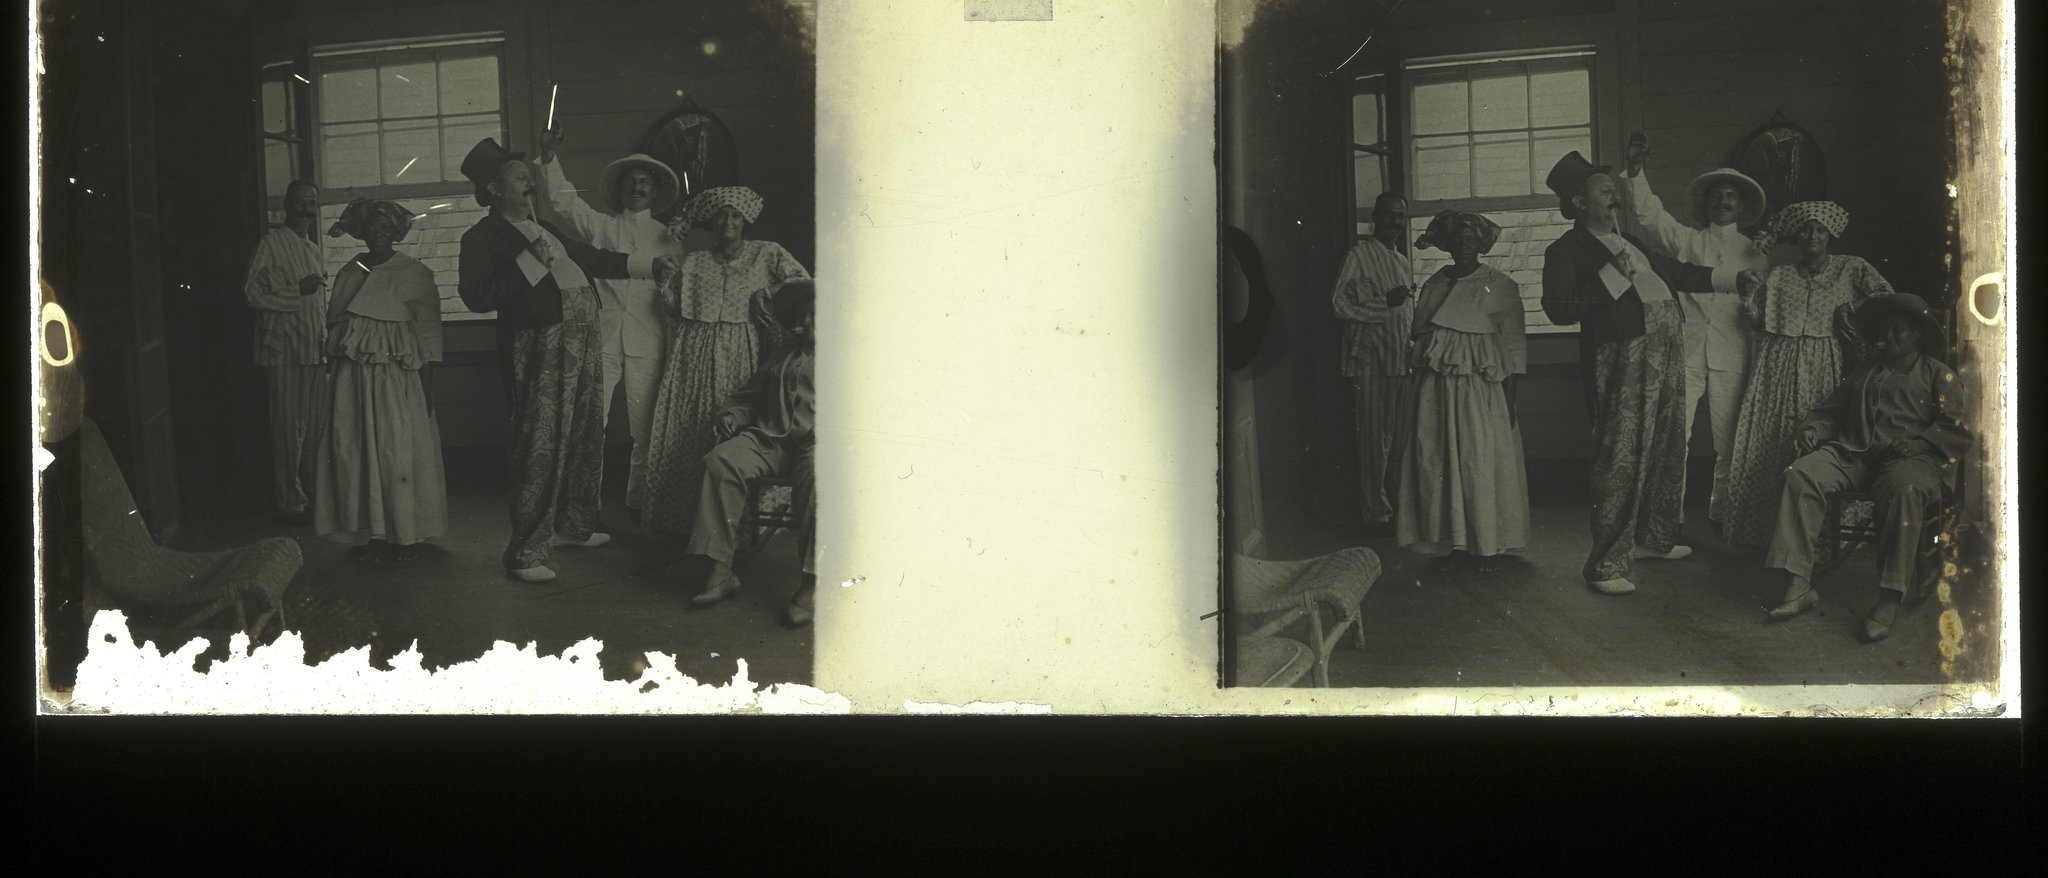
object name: stereograph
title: Interieur van het woonhuis plantage Accaribo met mensen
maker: theodoor brouwers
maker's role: amateurfotograaf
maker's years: 1874-1932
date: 1913-1930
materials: glass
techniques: photography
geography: suriname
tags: theodoor brouwers, plantation, suriname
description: In de periode 1911-1932 woonde op plantage Accaribo in Suriname de familie Brouwers van wie de foto's afkomstig zijn. Rond 1910 vond Theodoor Brouwers werk op plantage Accaribo. In 1929 werd hij eigenaar van de plantage. Op Accaribo werden in zijn tijd bananen geproduceerd en wat koffie.